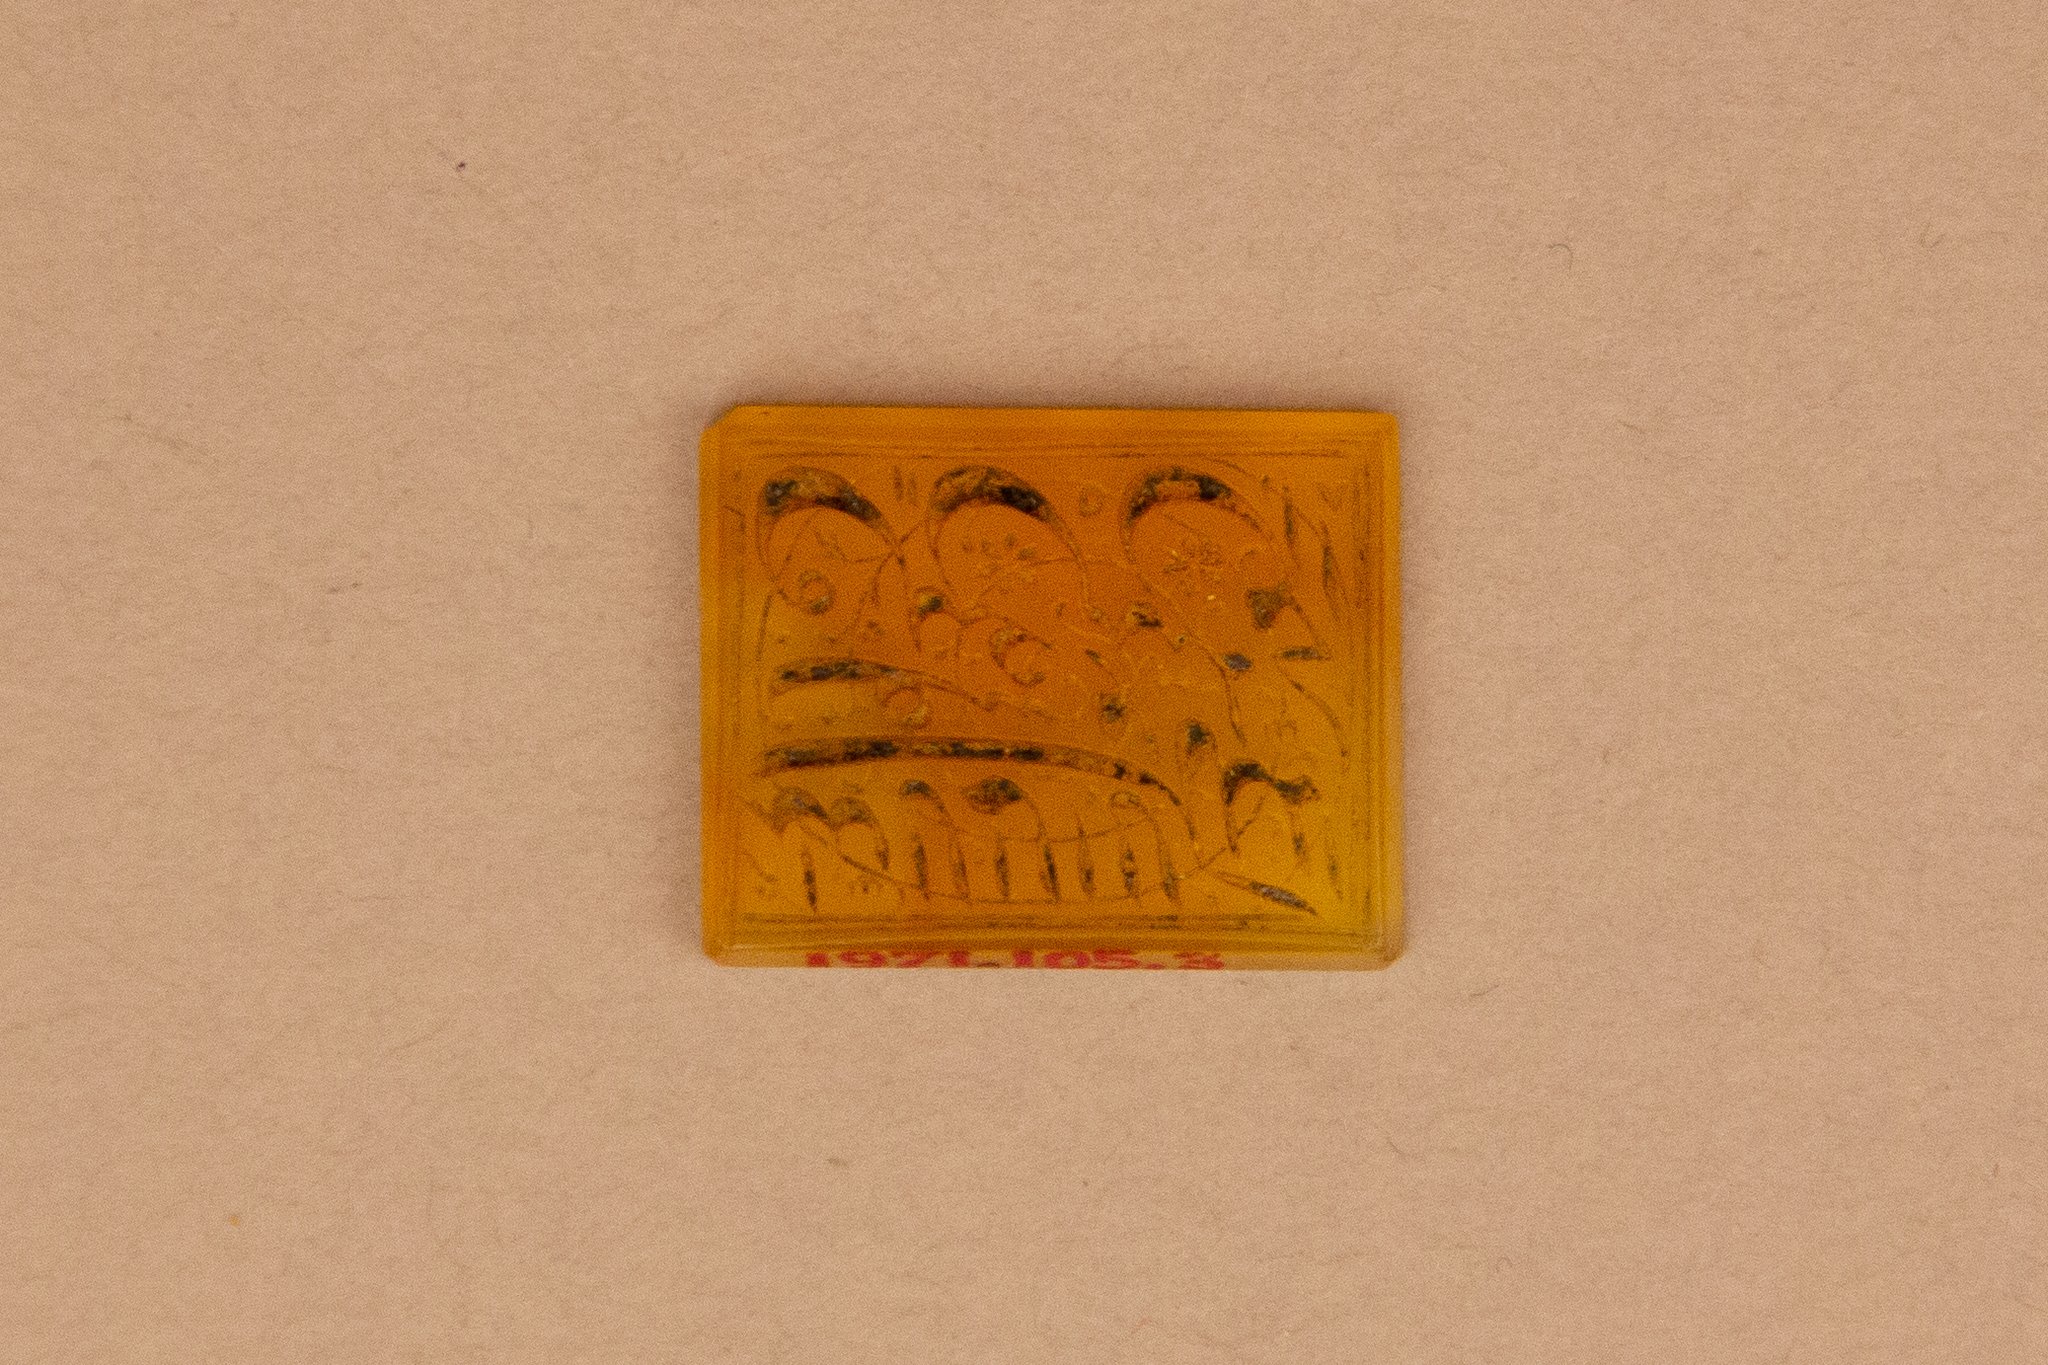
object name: seal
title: Seal Stone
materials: stone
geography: iran